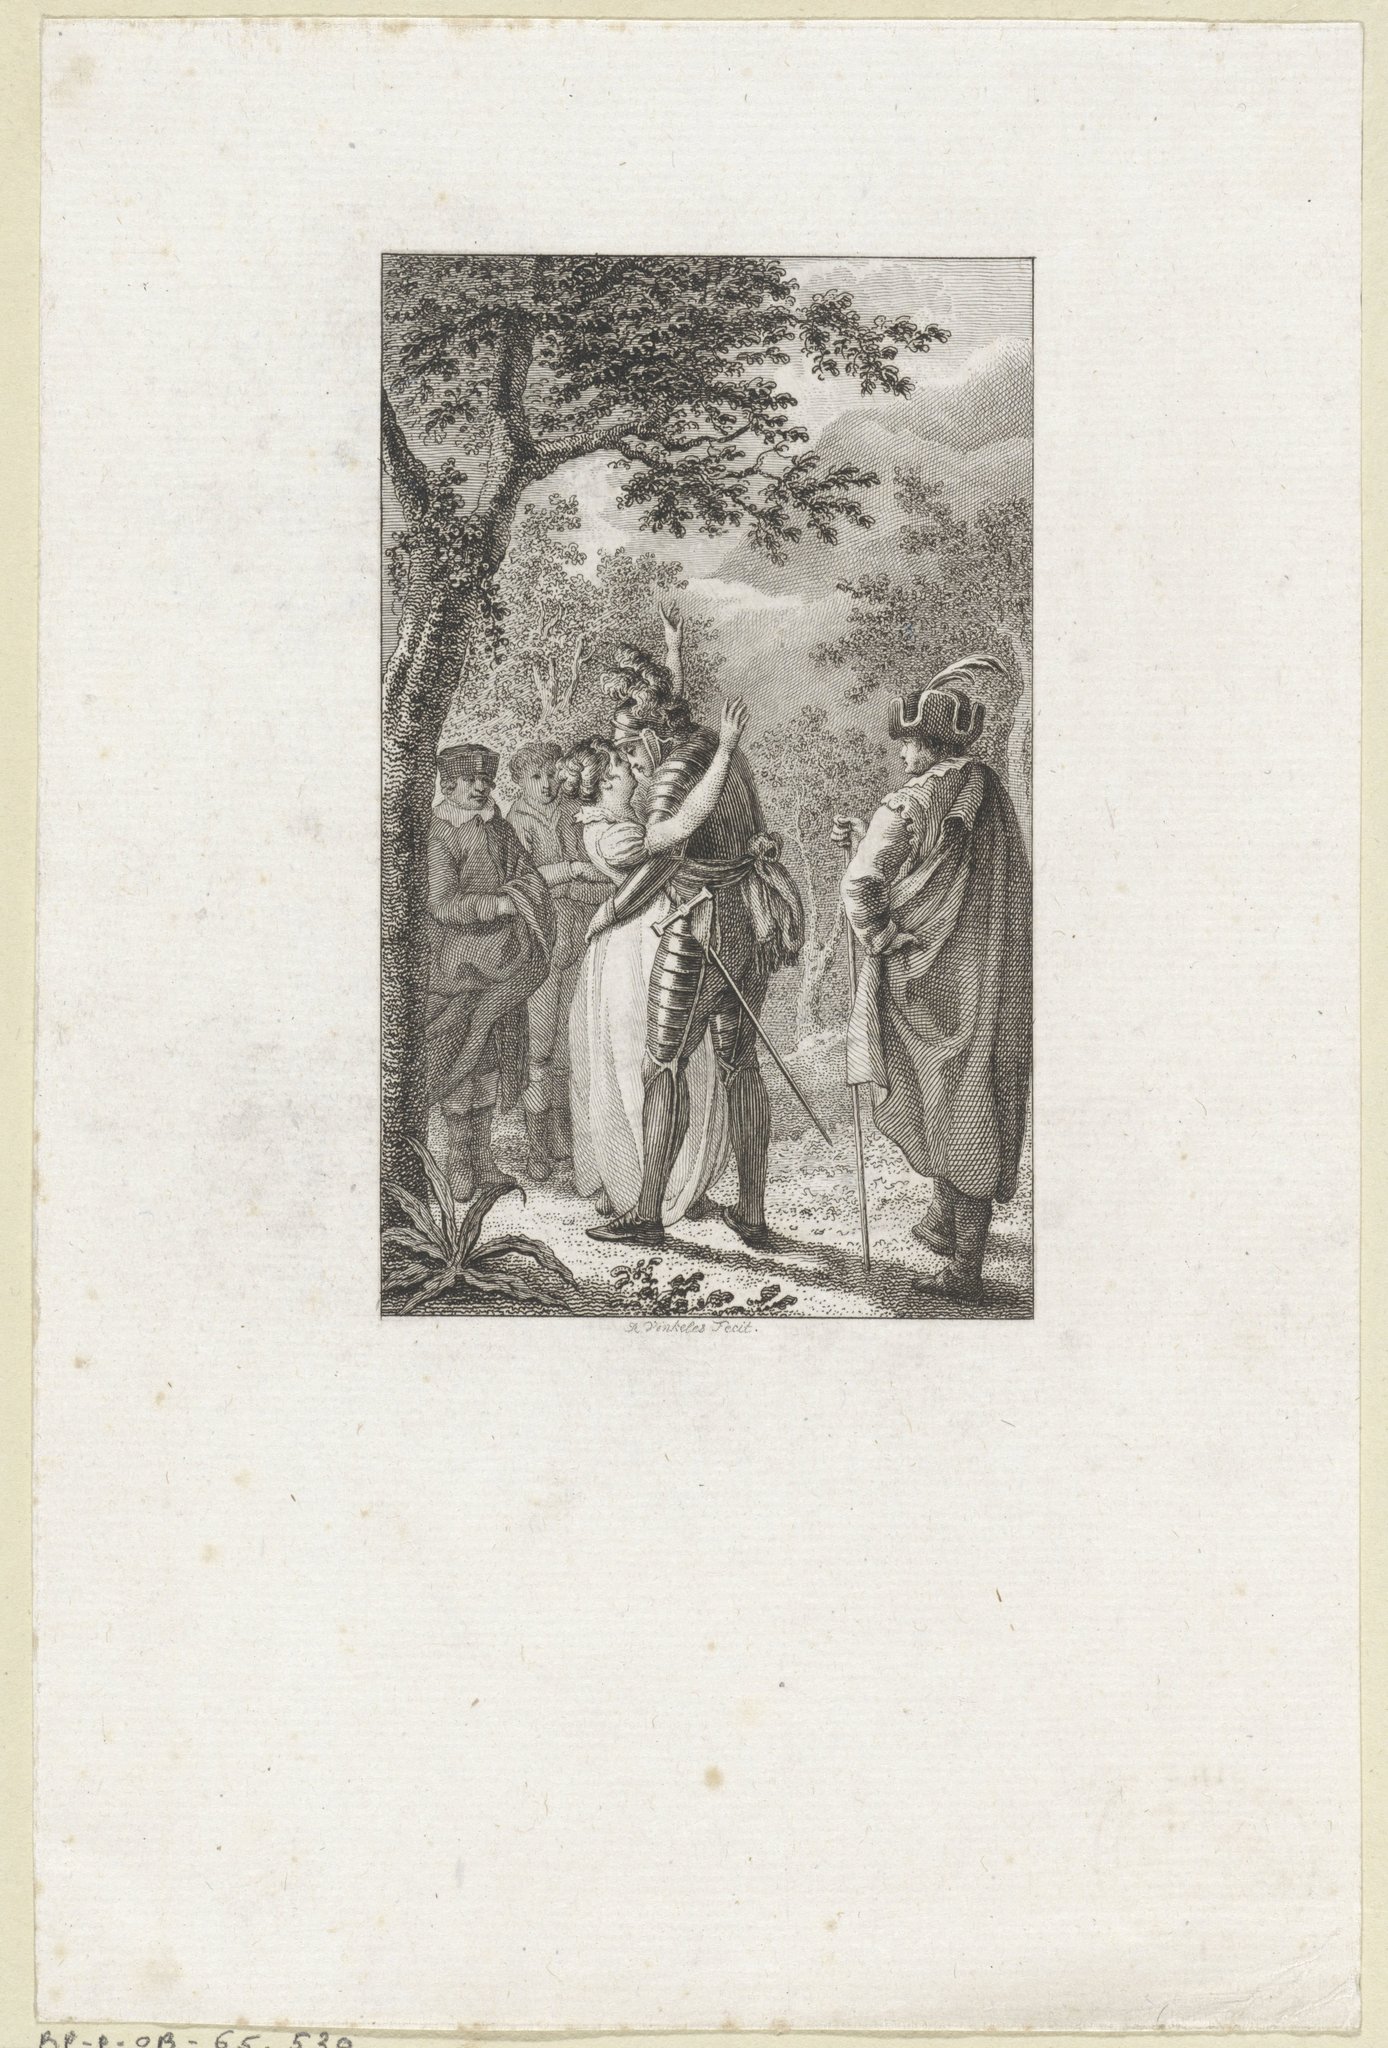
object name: print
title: Ridder omhelst een vrouw terwijl anderen toekijken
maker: reinier vinkeles (i)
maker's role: draughtsman, print maker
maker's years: 1741-1816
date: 1751-1816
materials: paper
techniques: engraving, etching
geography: amsterdam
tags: embracing each other, kissing, forest, wood, knight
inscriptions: collector's mark: Lugt 240